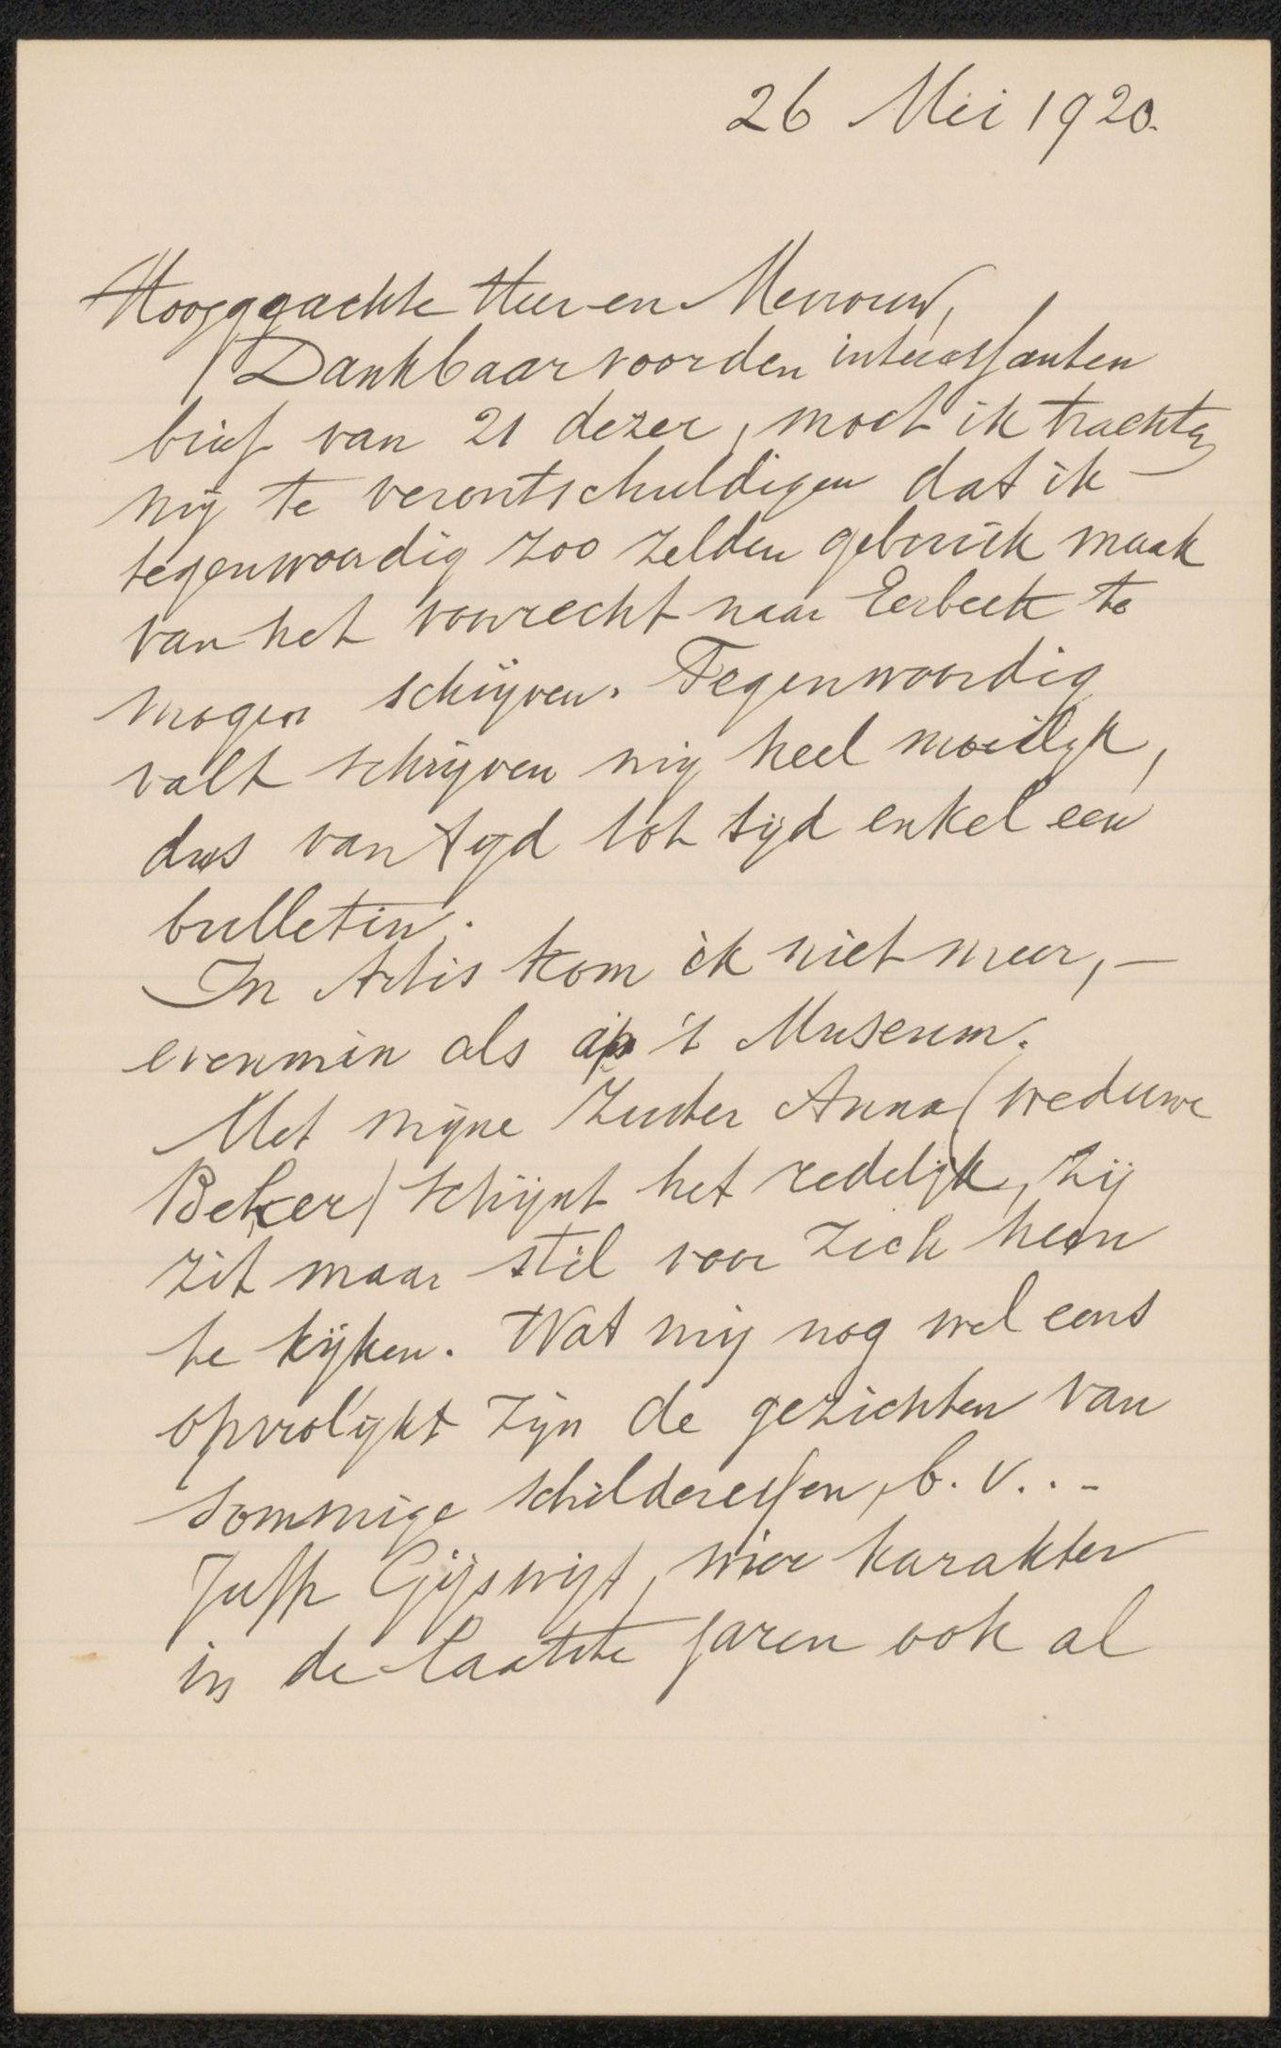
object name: letter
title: Brief aan Max Wilhelm Carl Weber en Anne Antoinette Weber-Van Bosse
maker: august allebé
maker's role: draughtsman, print maker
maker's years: 1838-1927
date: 1920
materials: ink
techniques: pen, writing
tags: anne antoinette weber-van bosse, amsterdam, agnieta cornelia gijswijt, painter, print maker, draughtsman, jan mankes